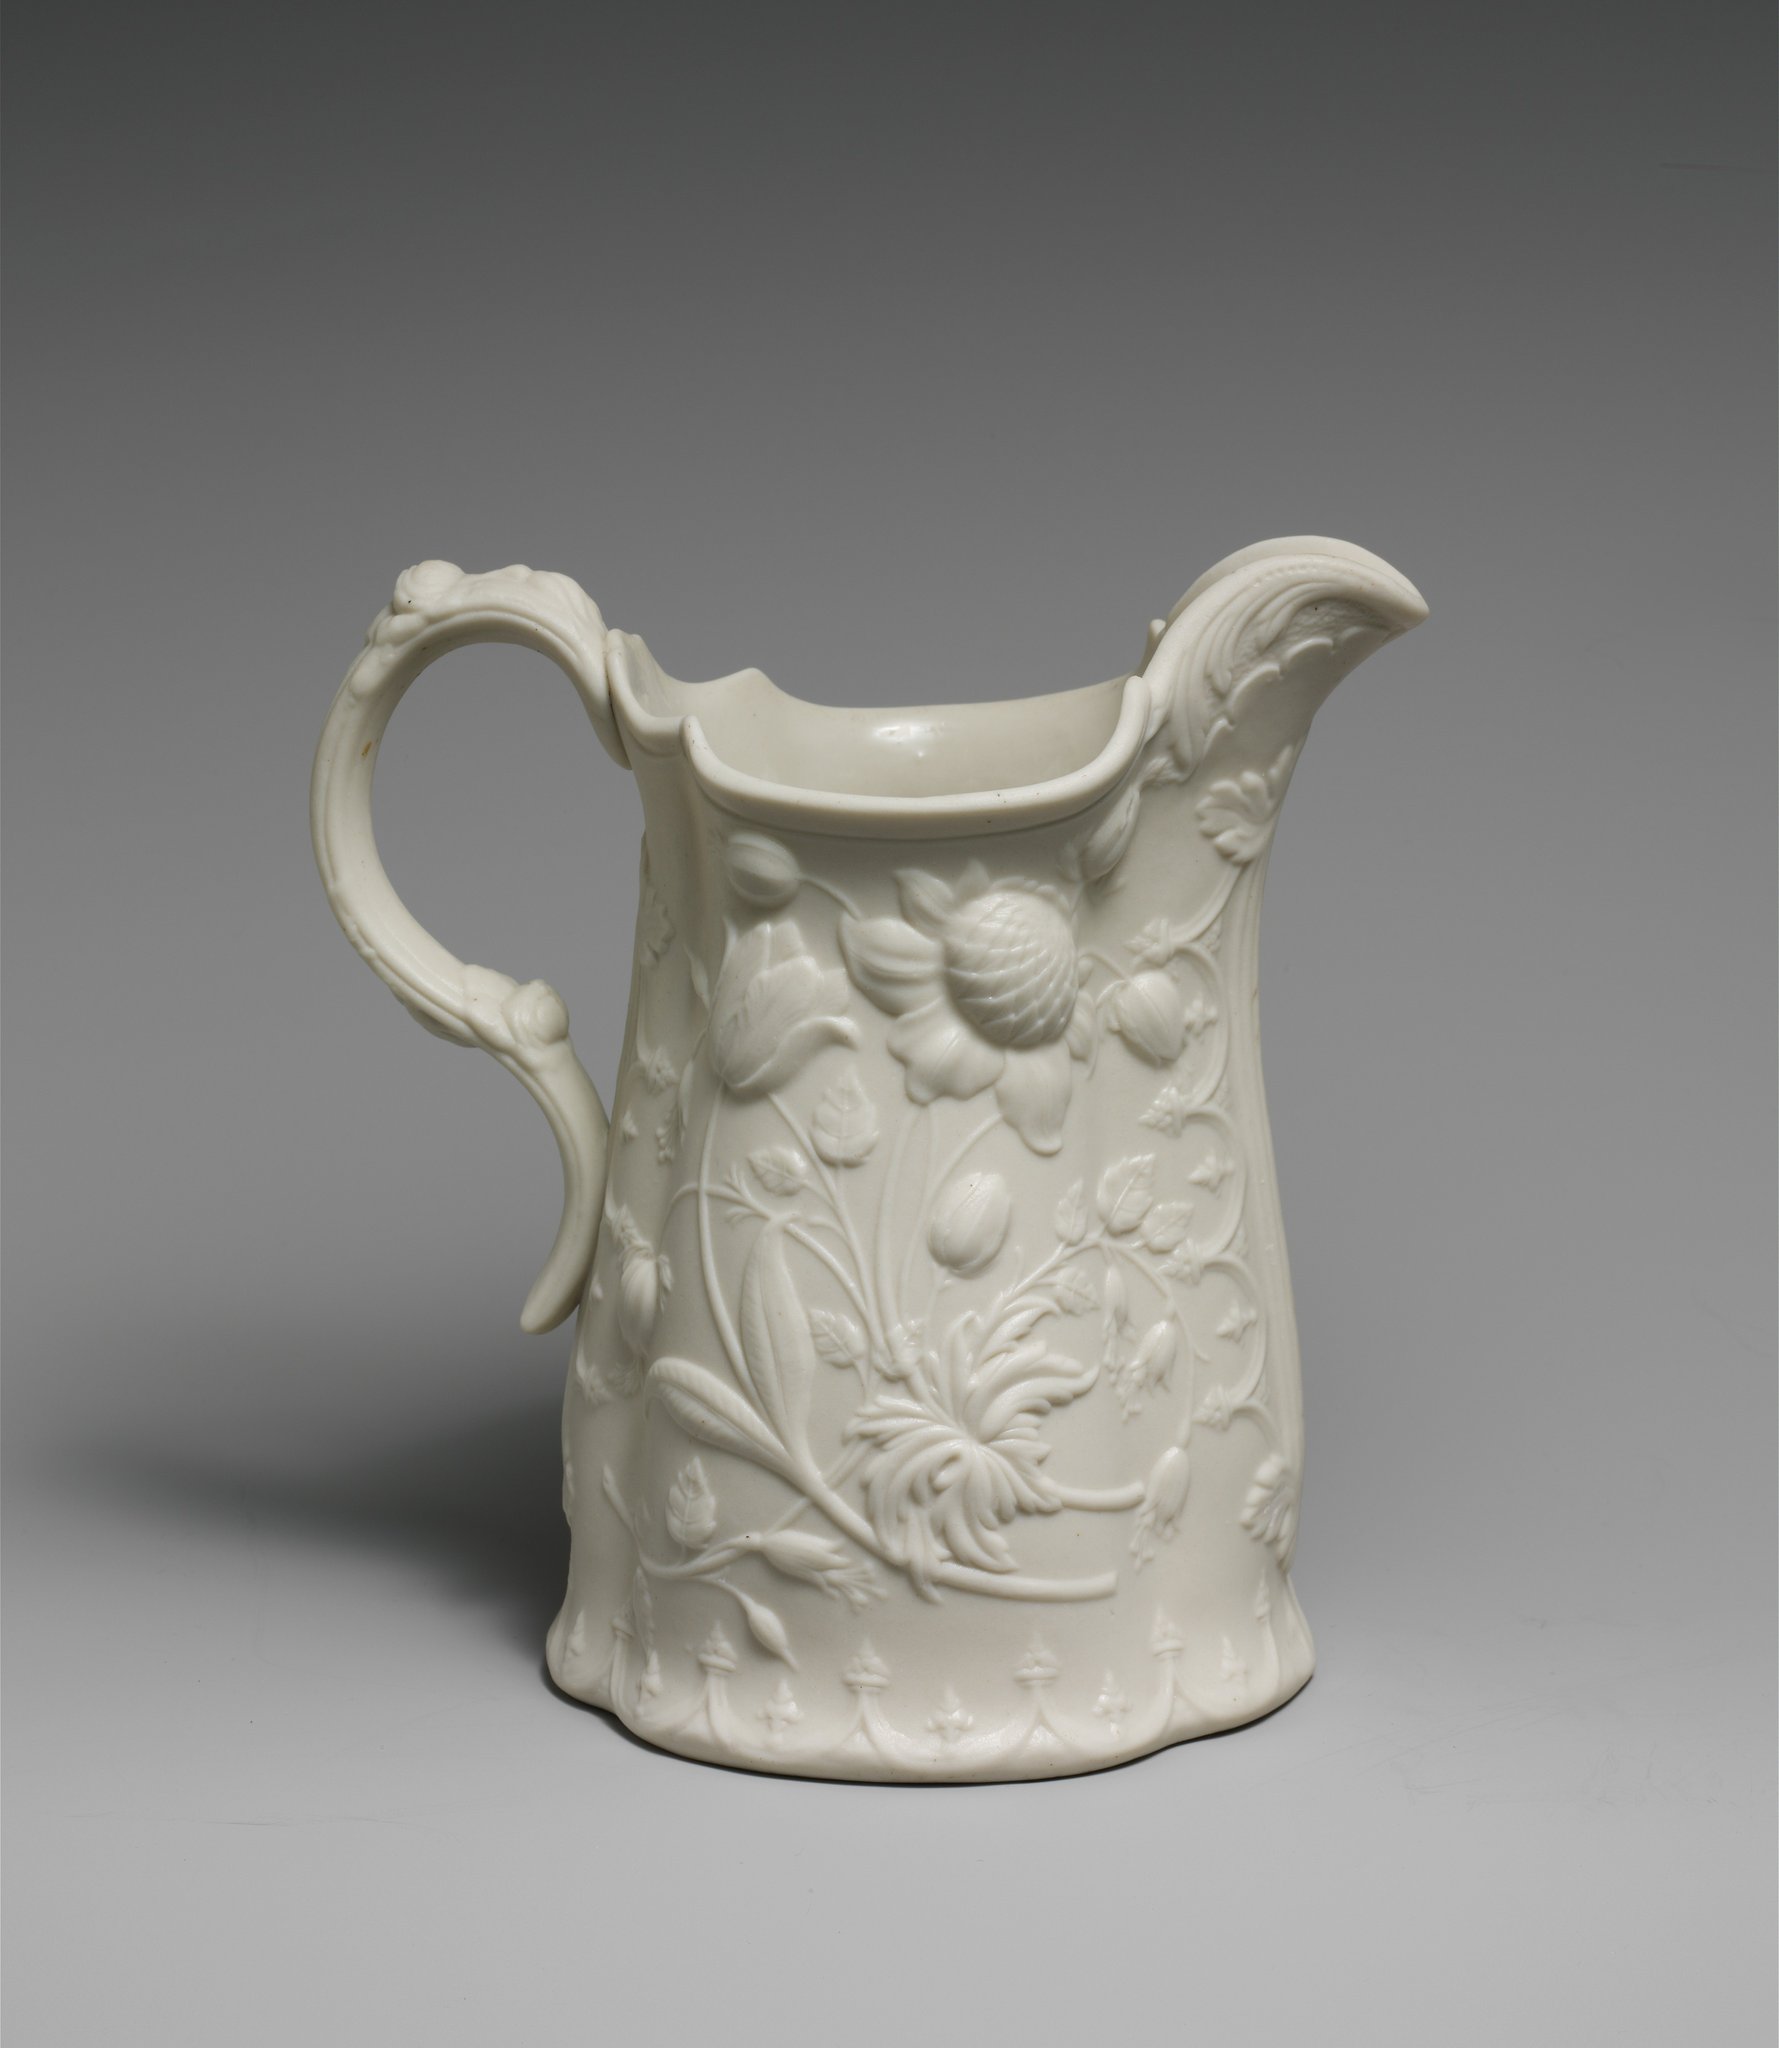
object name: pitcher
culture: american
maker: fenton's works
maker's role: maker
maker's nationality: american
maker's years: 1847-1848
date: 1847-1848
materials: porcelain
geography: united states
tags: flowers